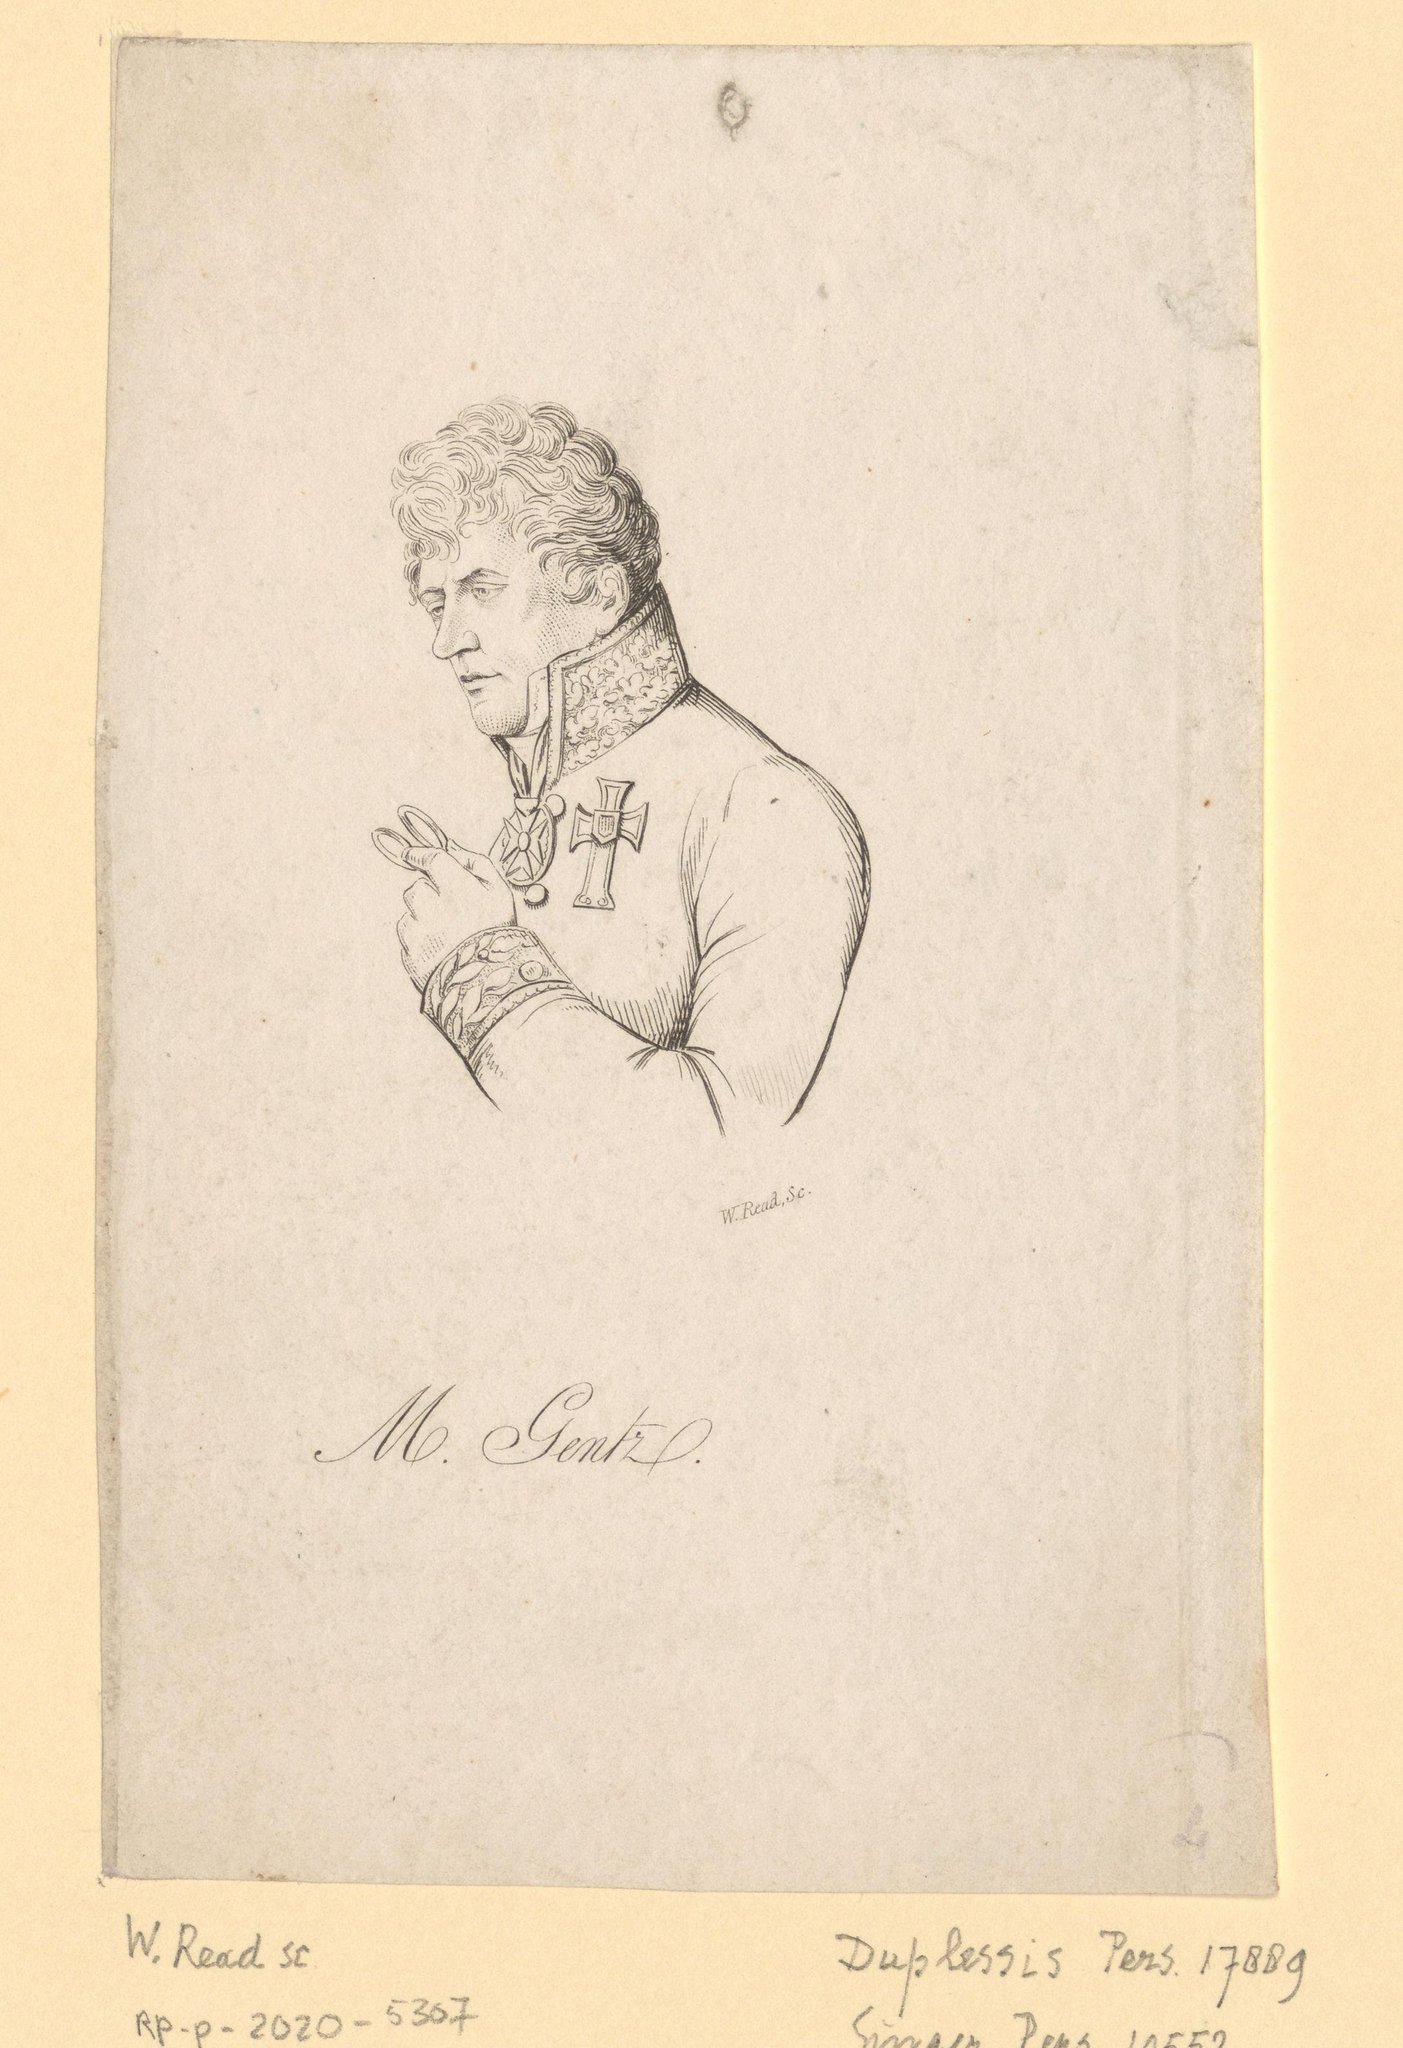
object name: print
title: Portret van Johann Friedrich Gentz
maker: w. read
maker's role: print maker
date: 1824-1837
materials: paper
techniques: etching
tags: commander-in-chief, general, marshal, historical persons